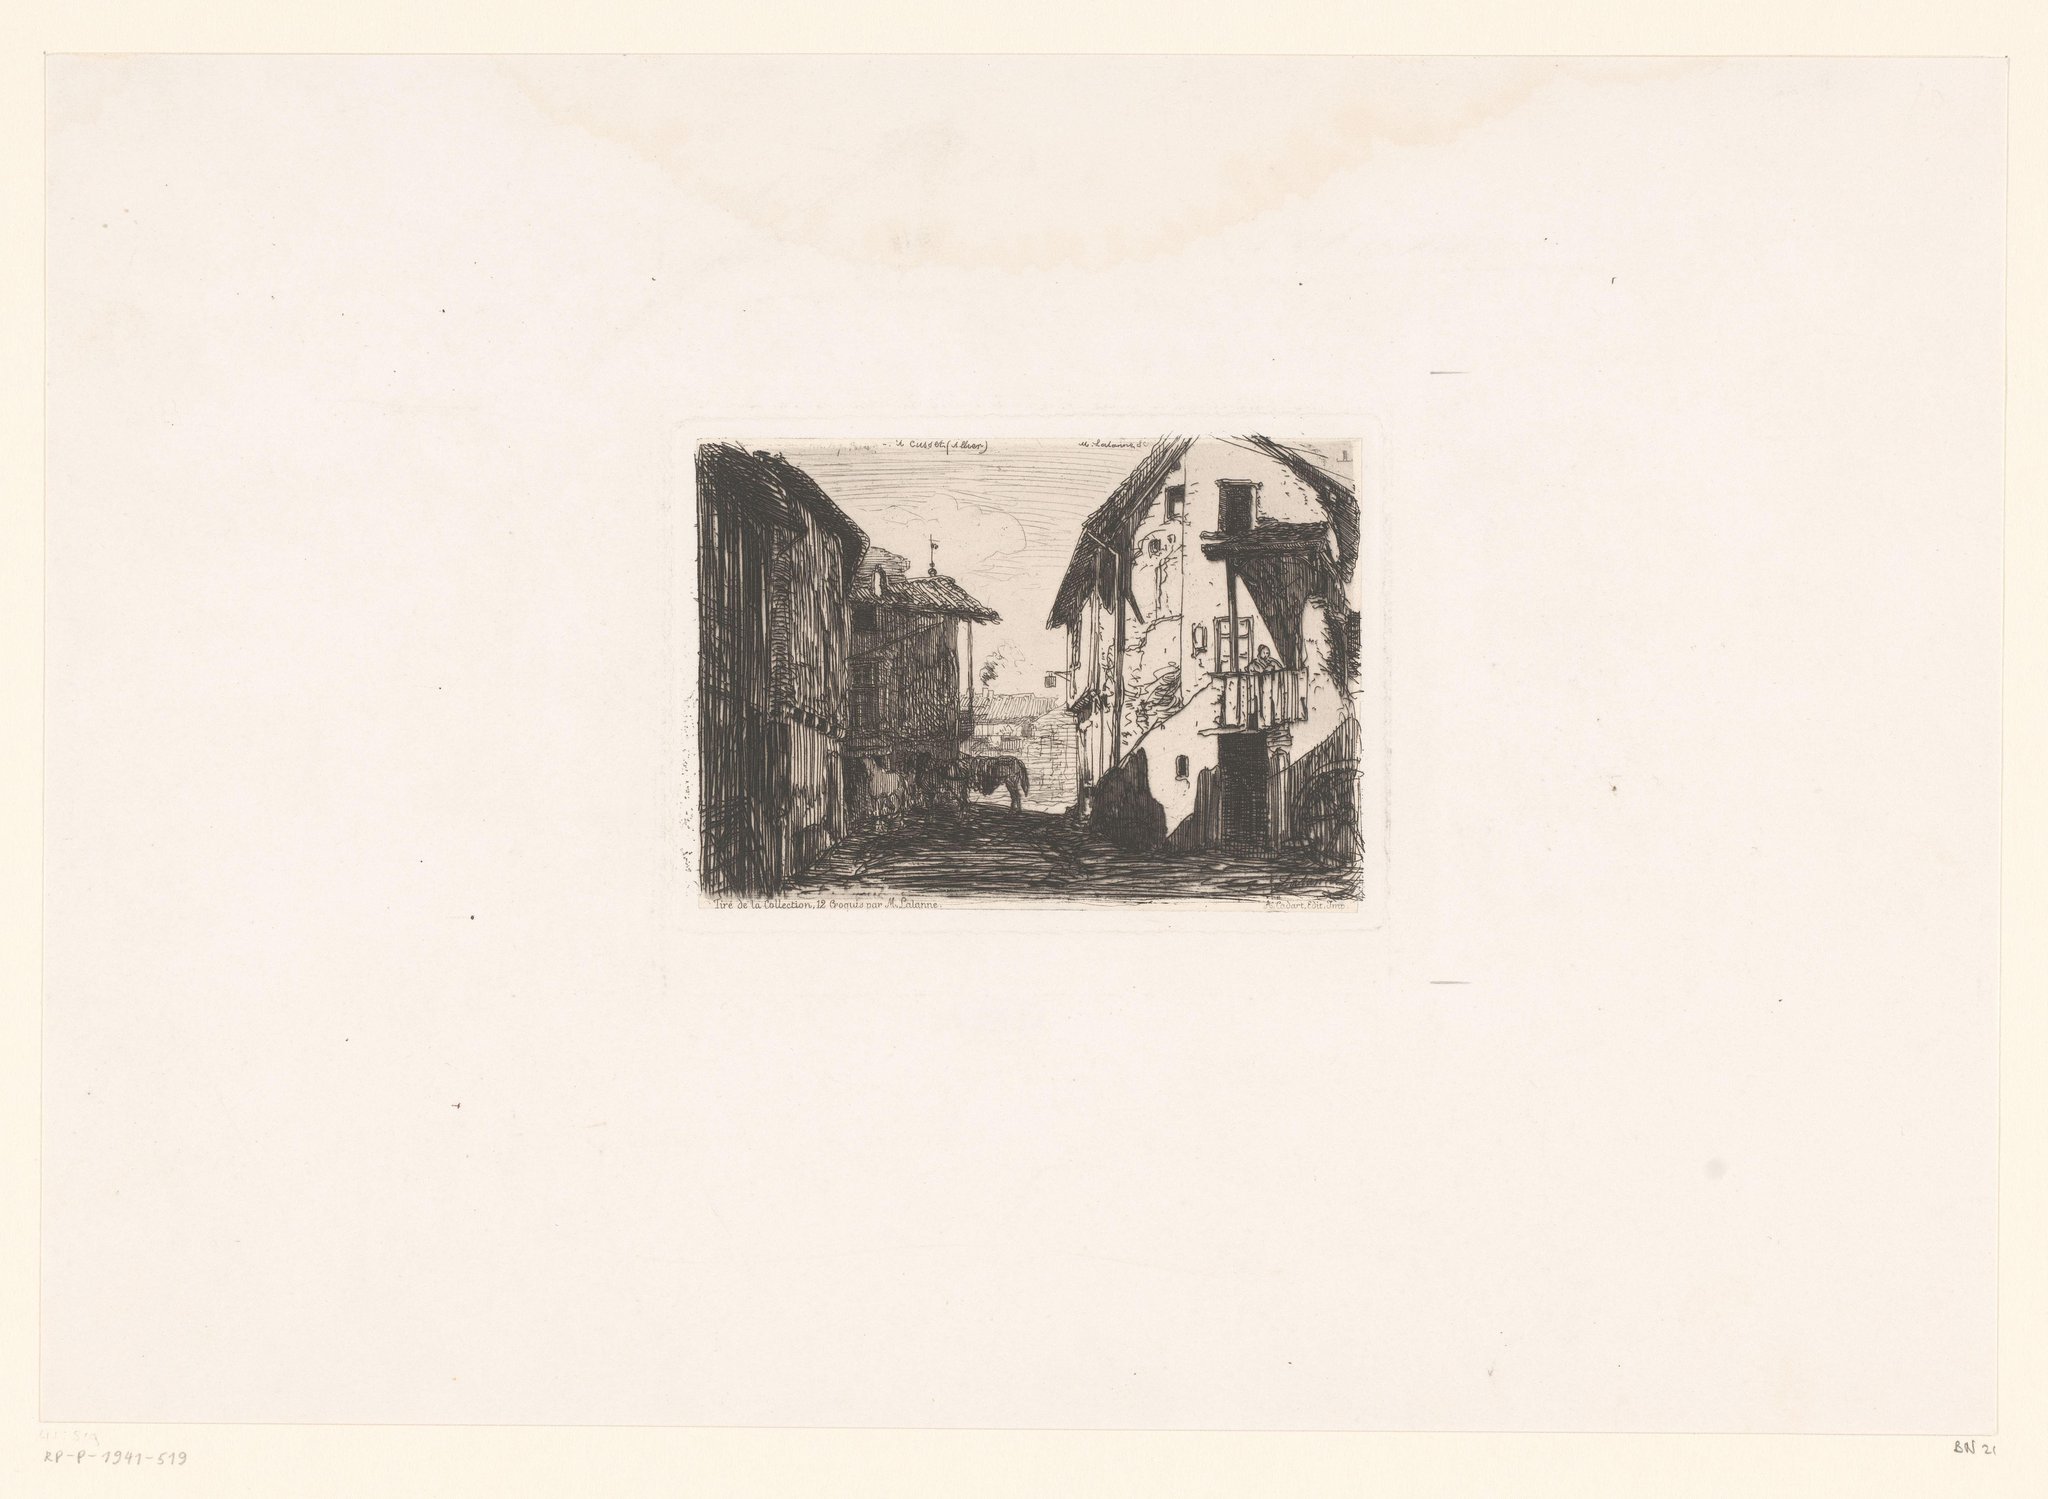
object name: print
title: À Cusset (Allier)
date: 1869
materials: paper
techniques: drypoint, engraving, etching, intaglio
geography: paris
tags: street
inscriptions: collector's mark: Lugt 2760, collector's mark: Lugt 2228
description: Gepubliceerd in: "Douze croquis à l'eau-forte (...)".